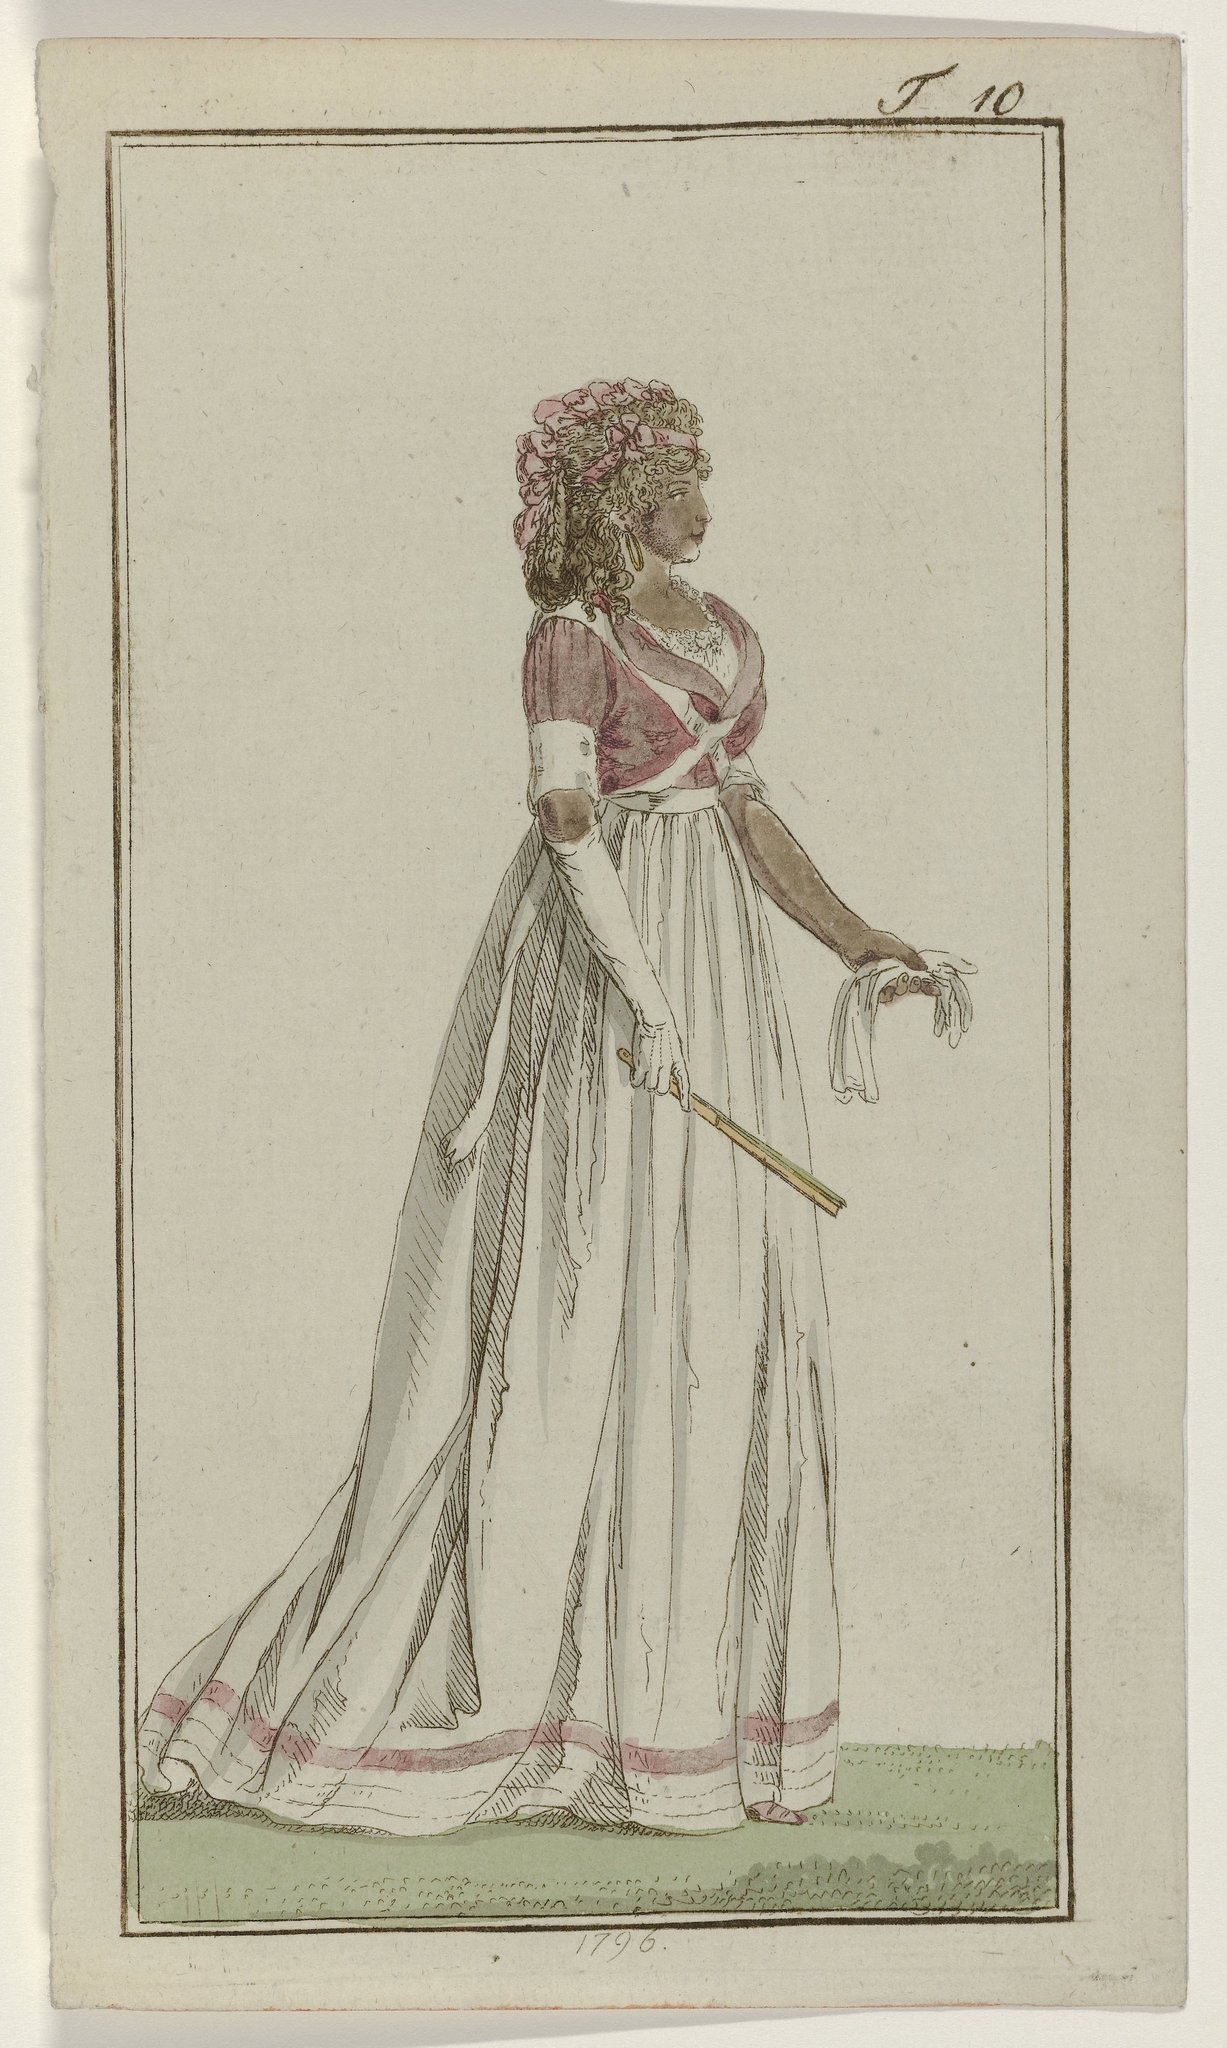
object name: fashion print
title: Journal des Luxus und der Moden, 1796, T 10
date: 1796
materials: paper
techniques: etching, hand coloring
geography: weimar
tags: ear-rings (+ women's clothes), gloves, mittens (long gloves) (+ women's clothes), border, ribbon, braid (+ women's clothes), fashion plates, dress, gown (+ women's clothes), fan (+ women's clothes)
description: Donkere vrouw in een japon met korte mouwen en sleepje. Het kapsel is versierd met linten. Verdere accessoires: oorring in het rechteroor, lange handschoenen, ceintuur, waaier. In de linkerhand een losse handschoen. Prent uit het modetijdschrift Journal des Luxus und der Moden, uitgegeven door Friedrich Justin Bertuch en Georg Melchior Kraus, Weimar, 1786-1826.